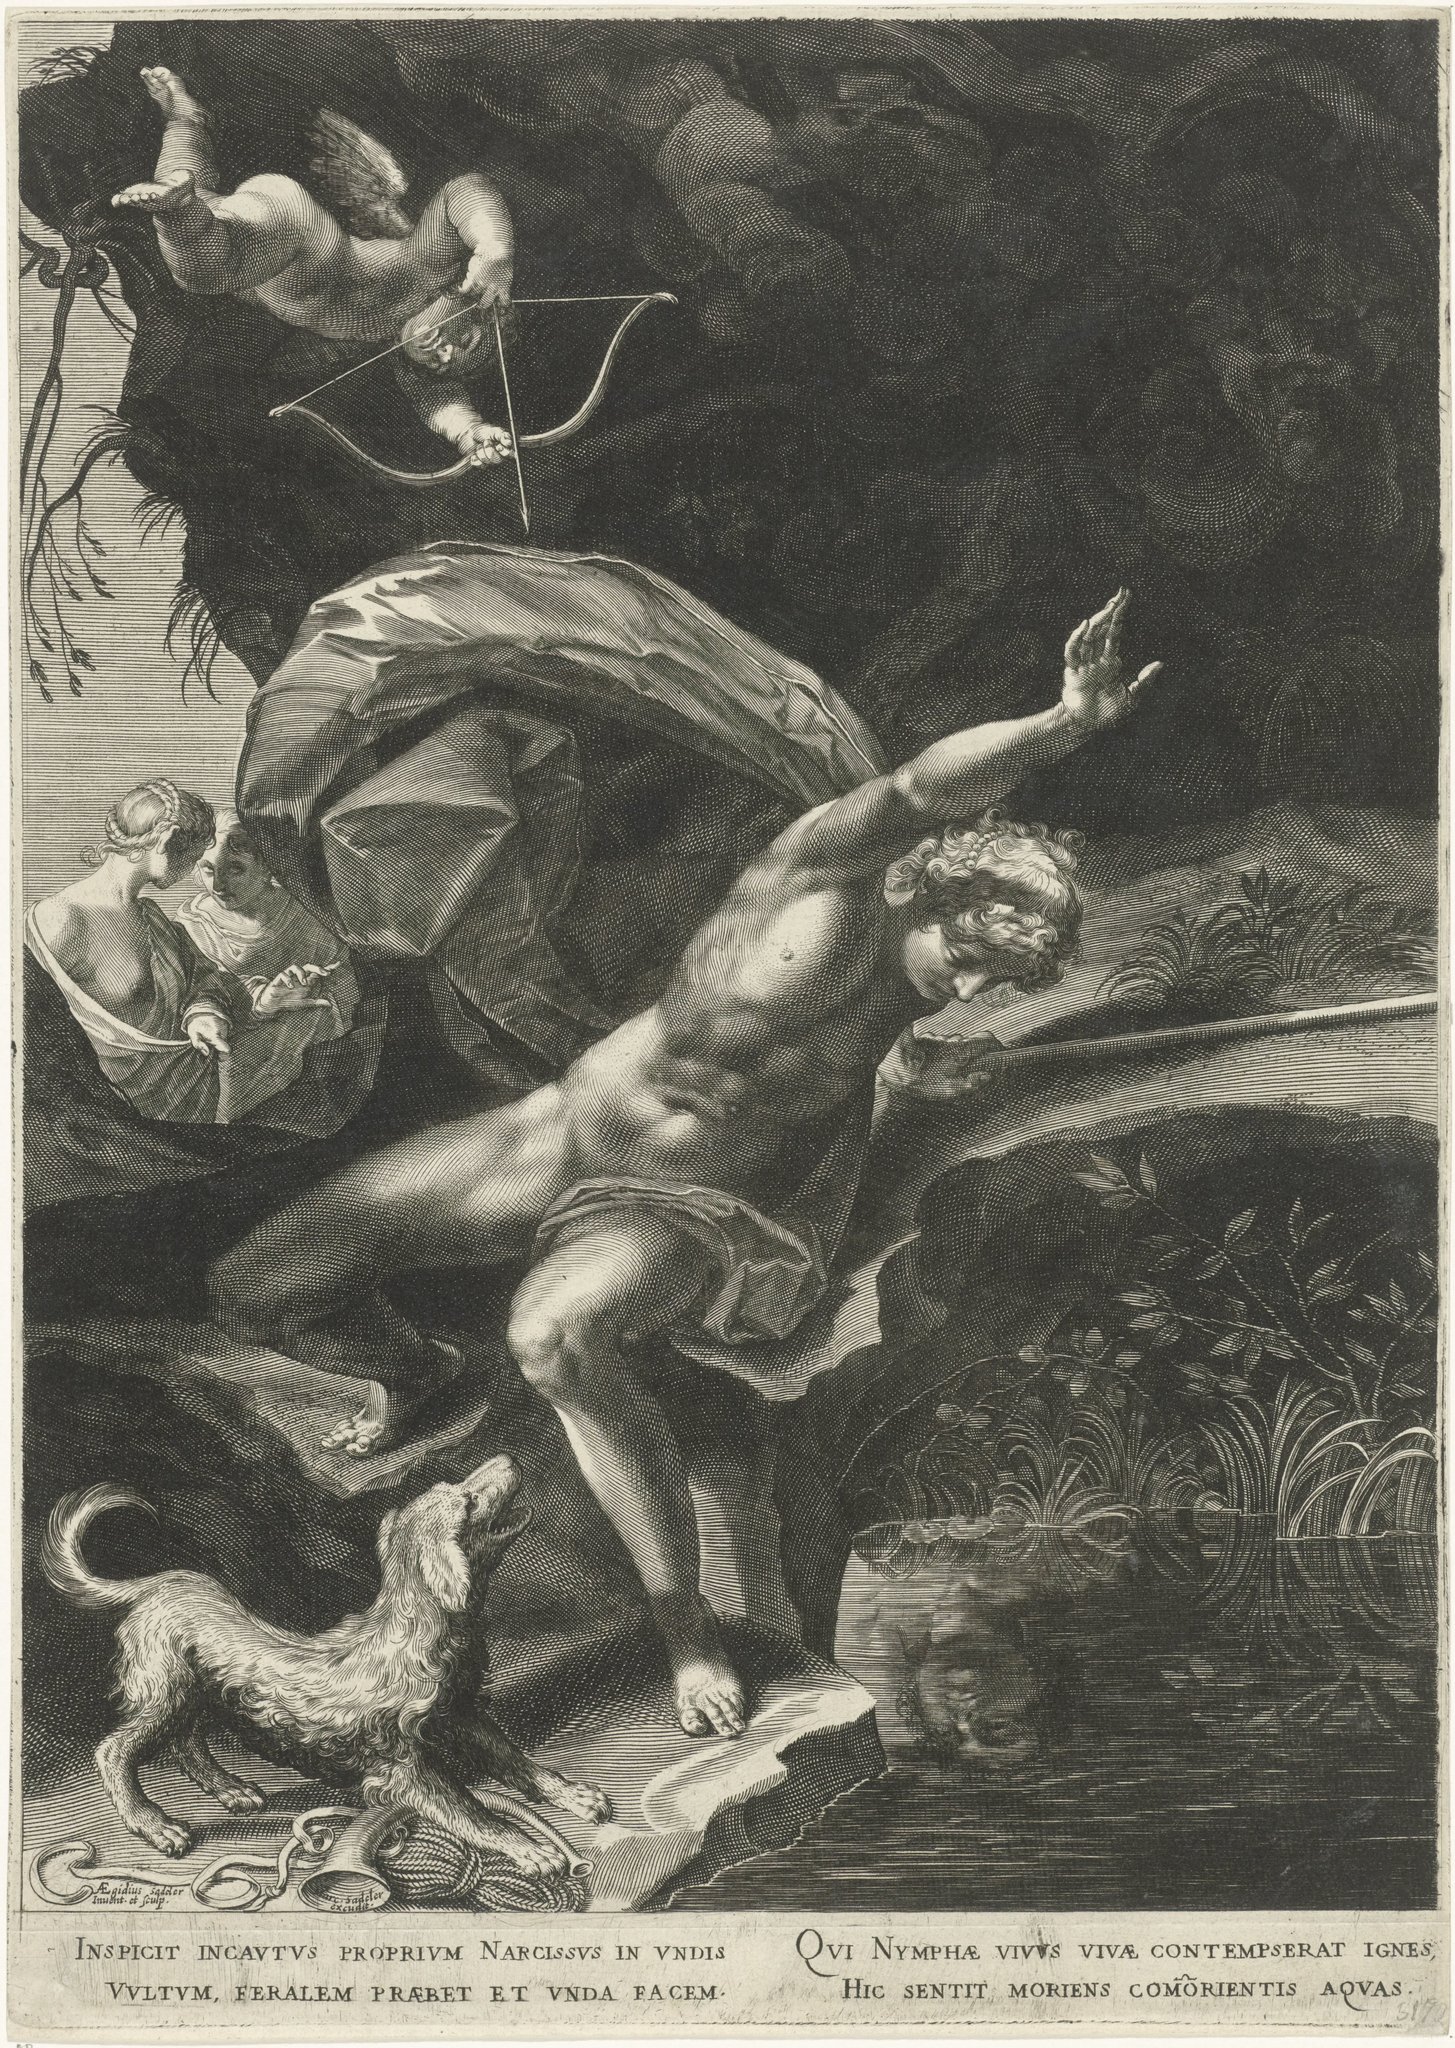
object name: print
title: Narcissus Aegidius Sadeler (II) (ca. 1570-1629)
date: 1580-1629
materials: paper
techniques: engraving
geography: venice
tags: narcissus changed into a narcissus: when narcissus is pining away for the love of his image reflected from the water, he is changed into a narcissus (ovid, metamorphoses iii 510)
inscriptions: collector's mark: Lugt 240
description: Two nymphs watch Narcissus as he is about to lose himself. In the sky, Cupid draws his bow to shoot an arrow of love. The scene is full of movement, from the attentive dog to Narcissus’ billowing clothes. Bartholomeus Spranger and Aegidius Sadeler worked in the service of Emperor Rudolf II in Prague, where they collaborated intensively.